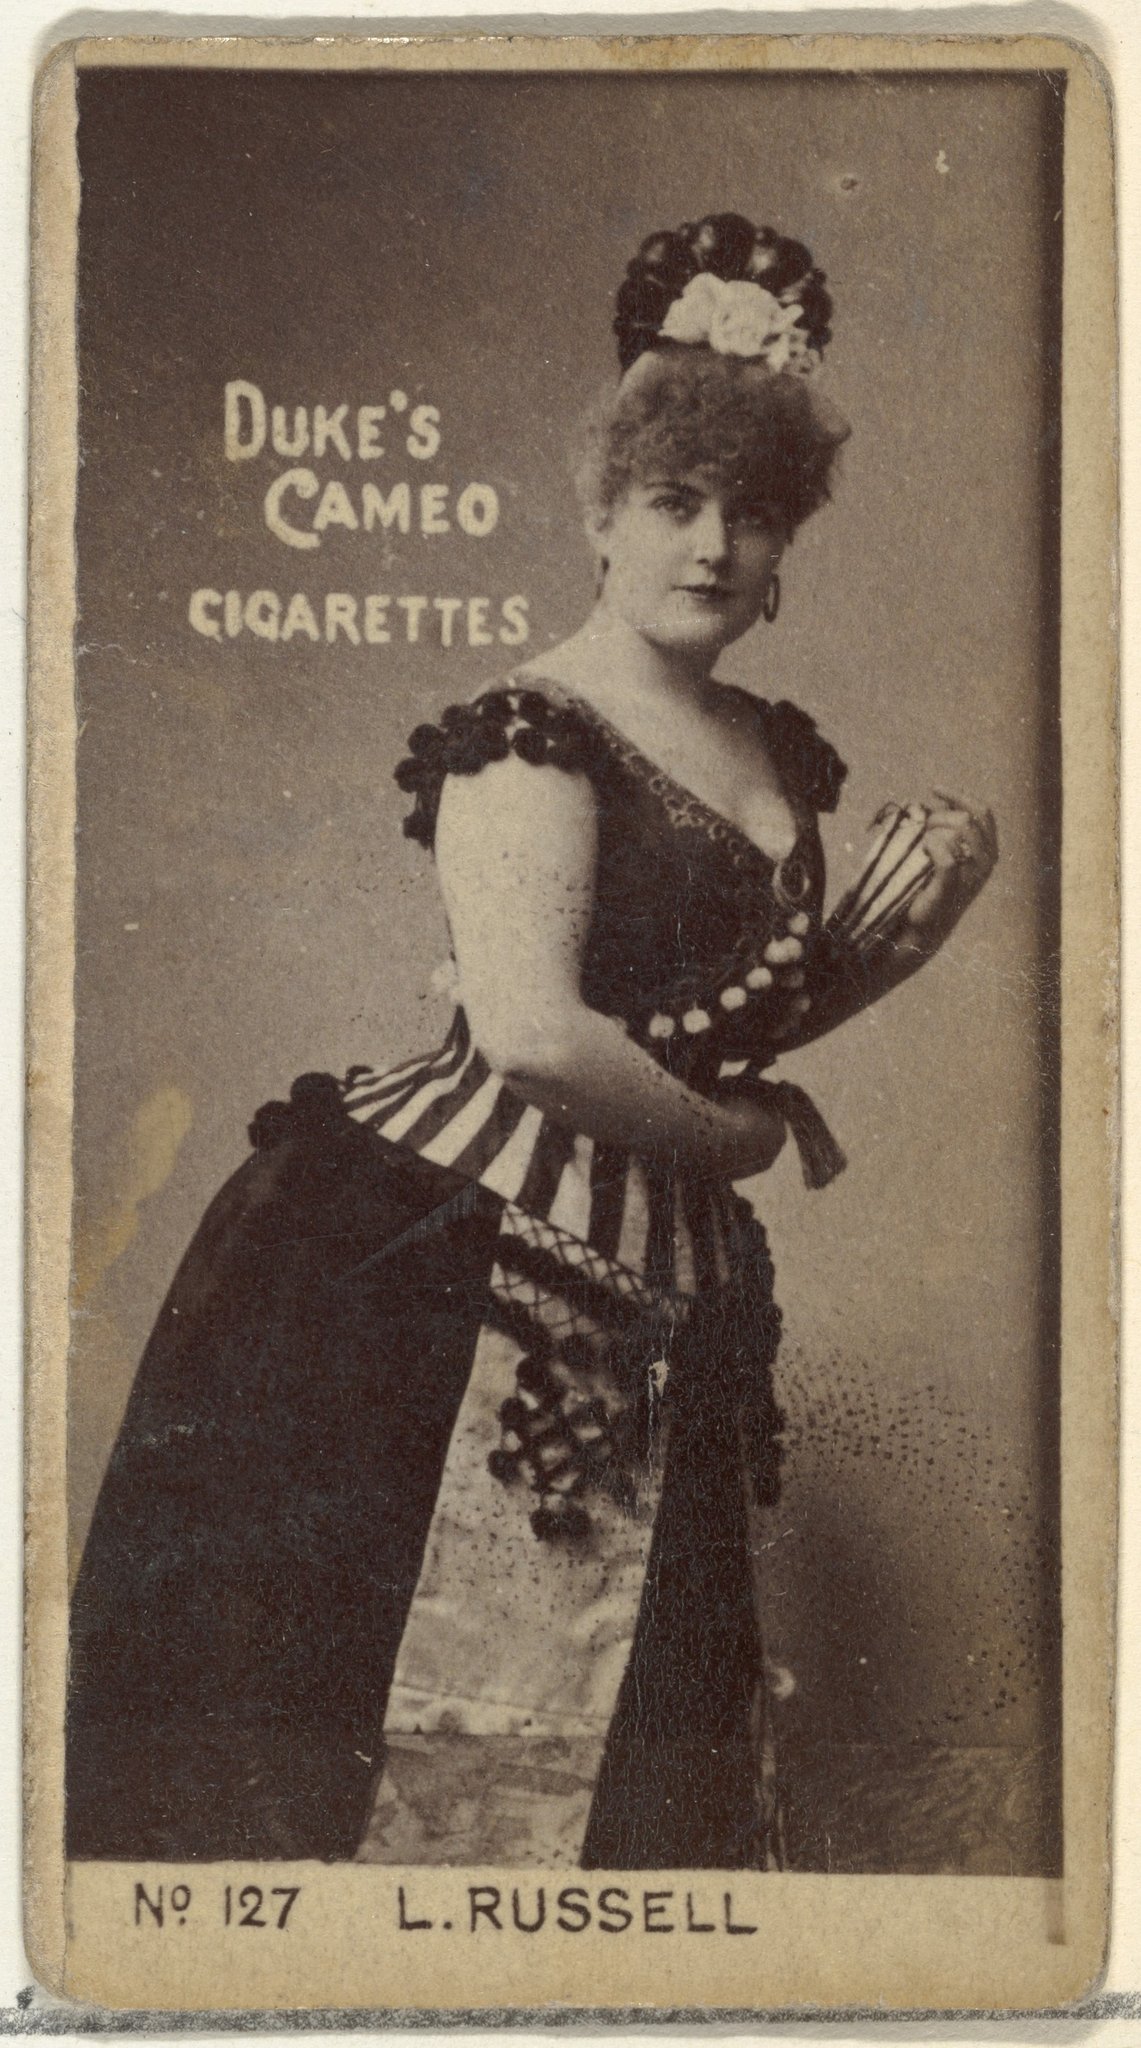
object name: photograph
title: Card Number 127, Lillian Russell, from the Actors and Actresses series (N145-4) issued by Duke Sons & Co. to promote Cameo Cigarettes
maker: w. duke, sons & co.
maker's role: publisher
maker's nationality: american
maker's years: 1870-1920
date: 1880-1889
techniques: albumen silver print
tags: portraits,women,actresses